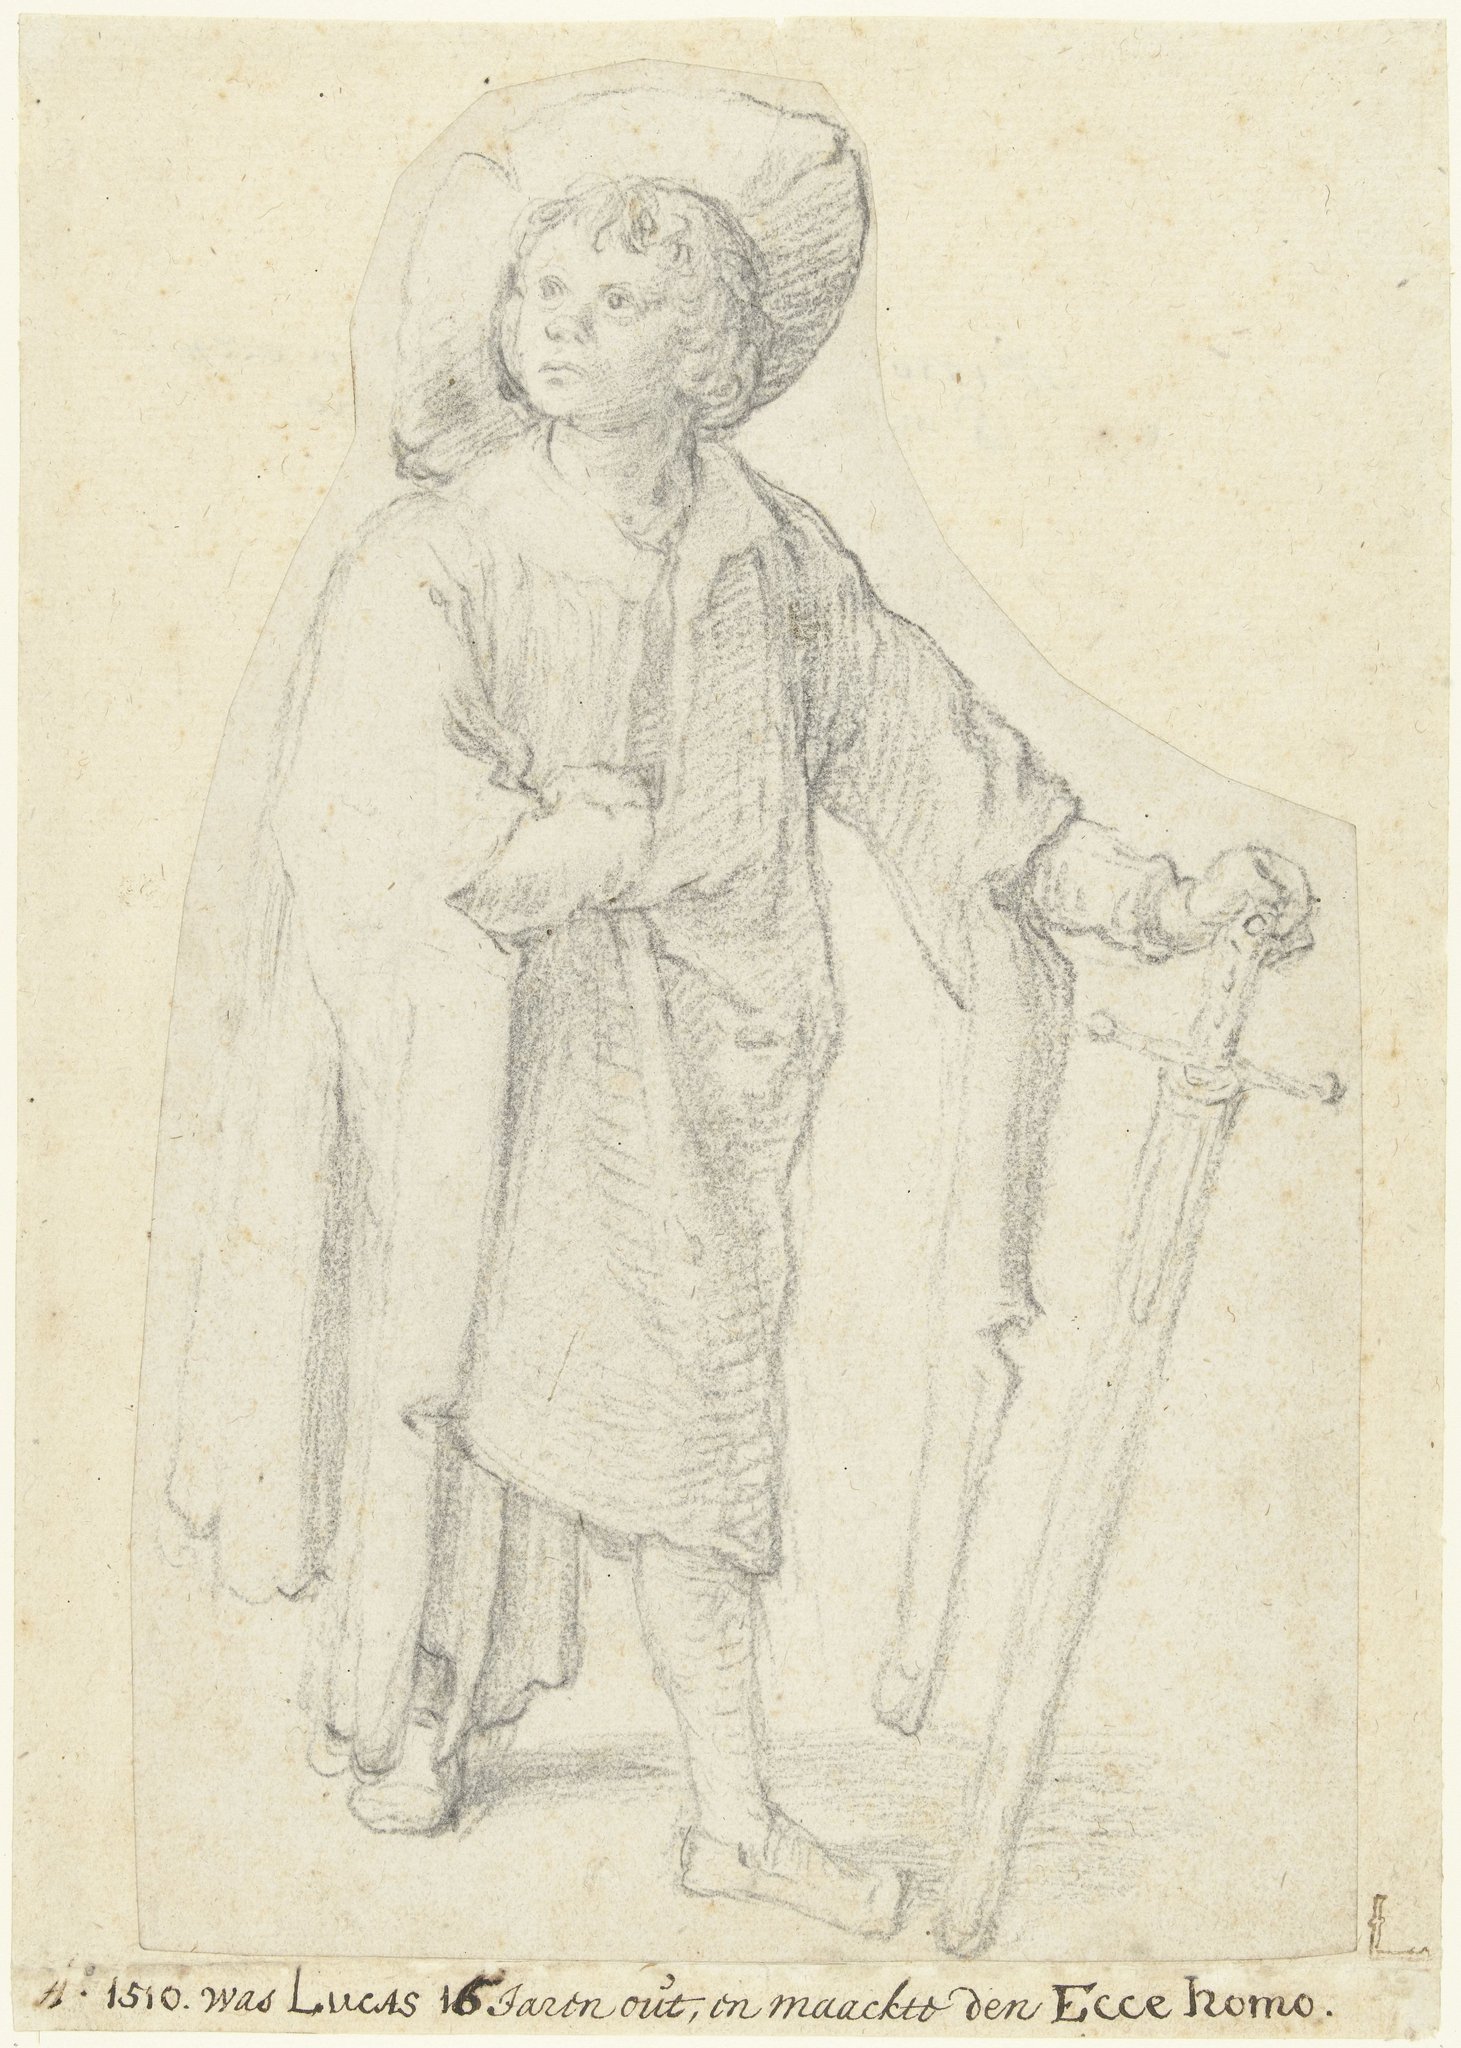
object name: drawing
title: Staande jongen met zwaard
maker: lucas van leyden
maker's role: draughtsman, painter, print maker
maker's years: 1494-1533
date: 1508-1512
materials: chalk, paper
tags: standing figure, hacking and thrusting weapons: sword